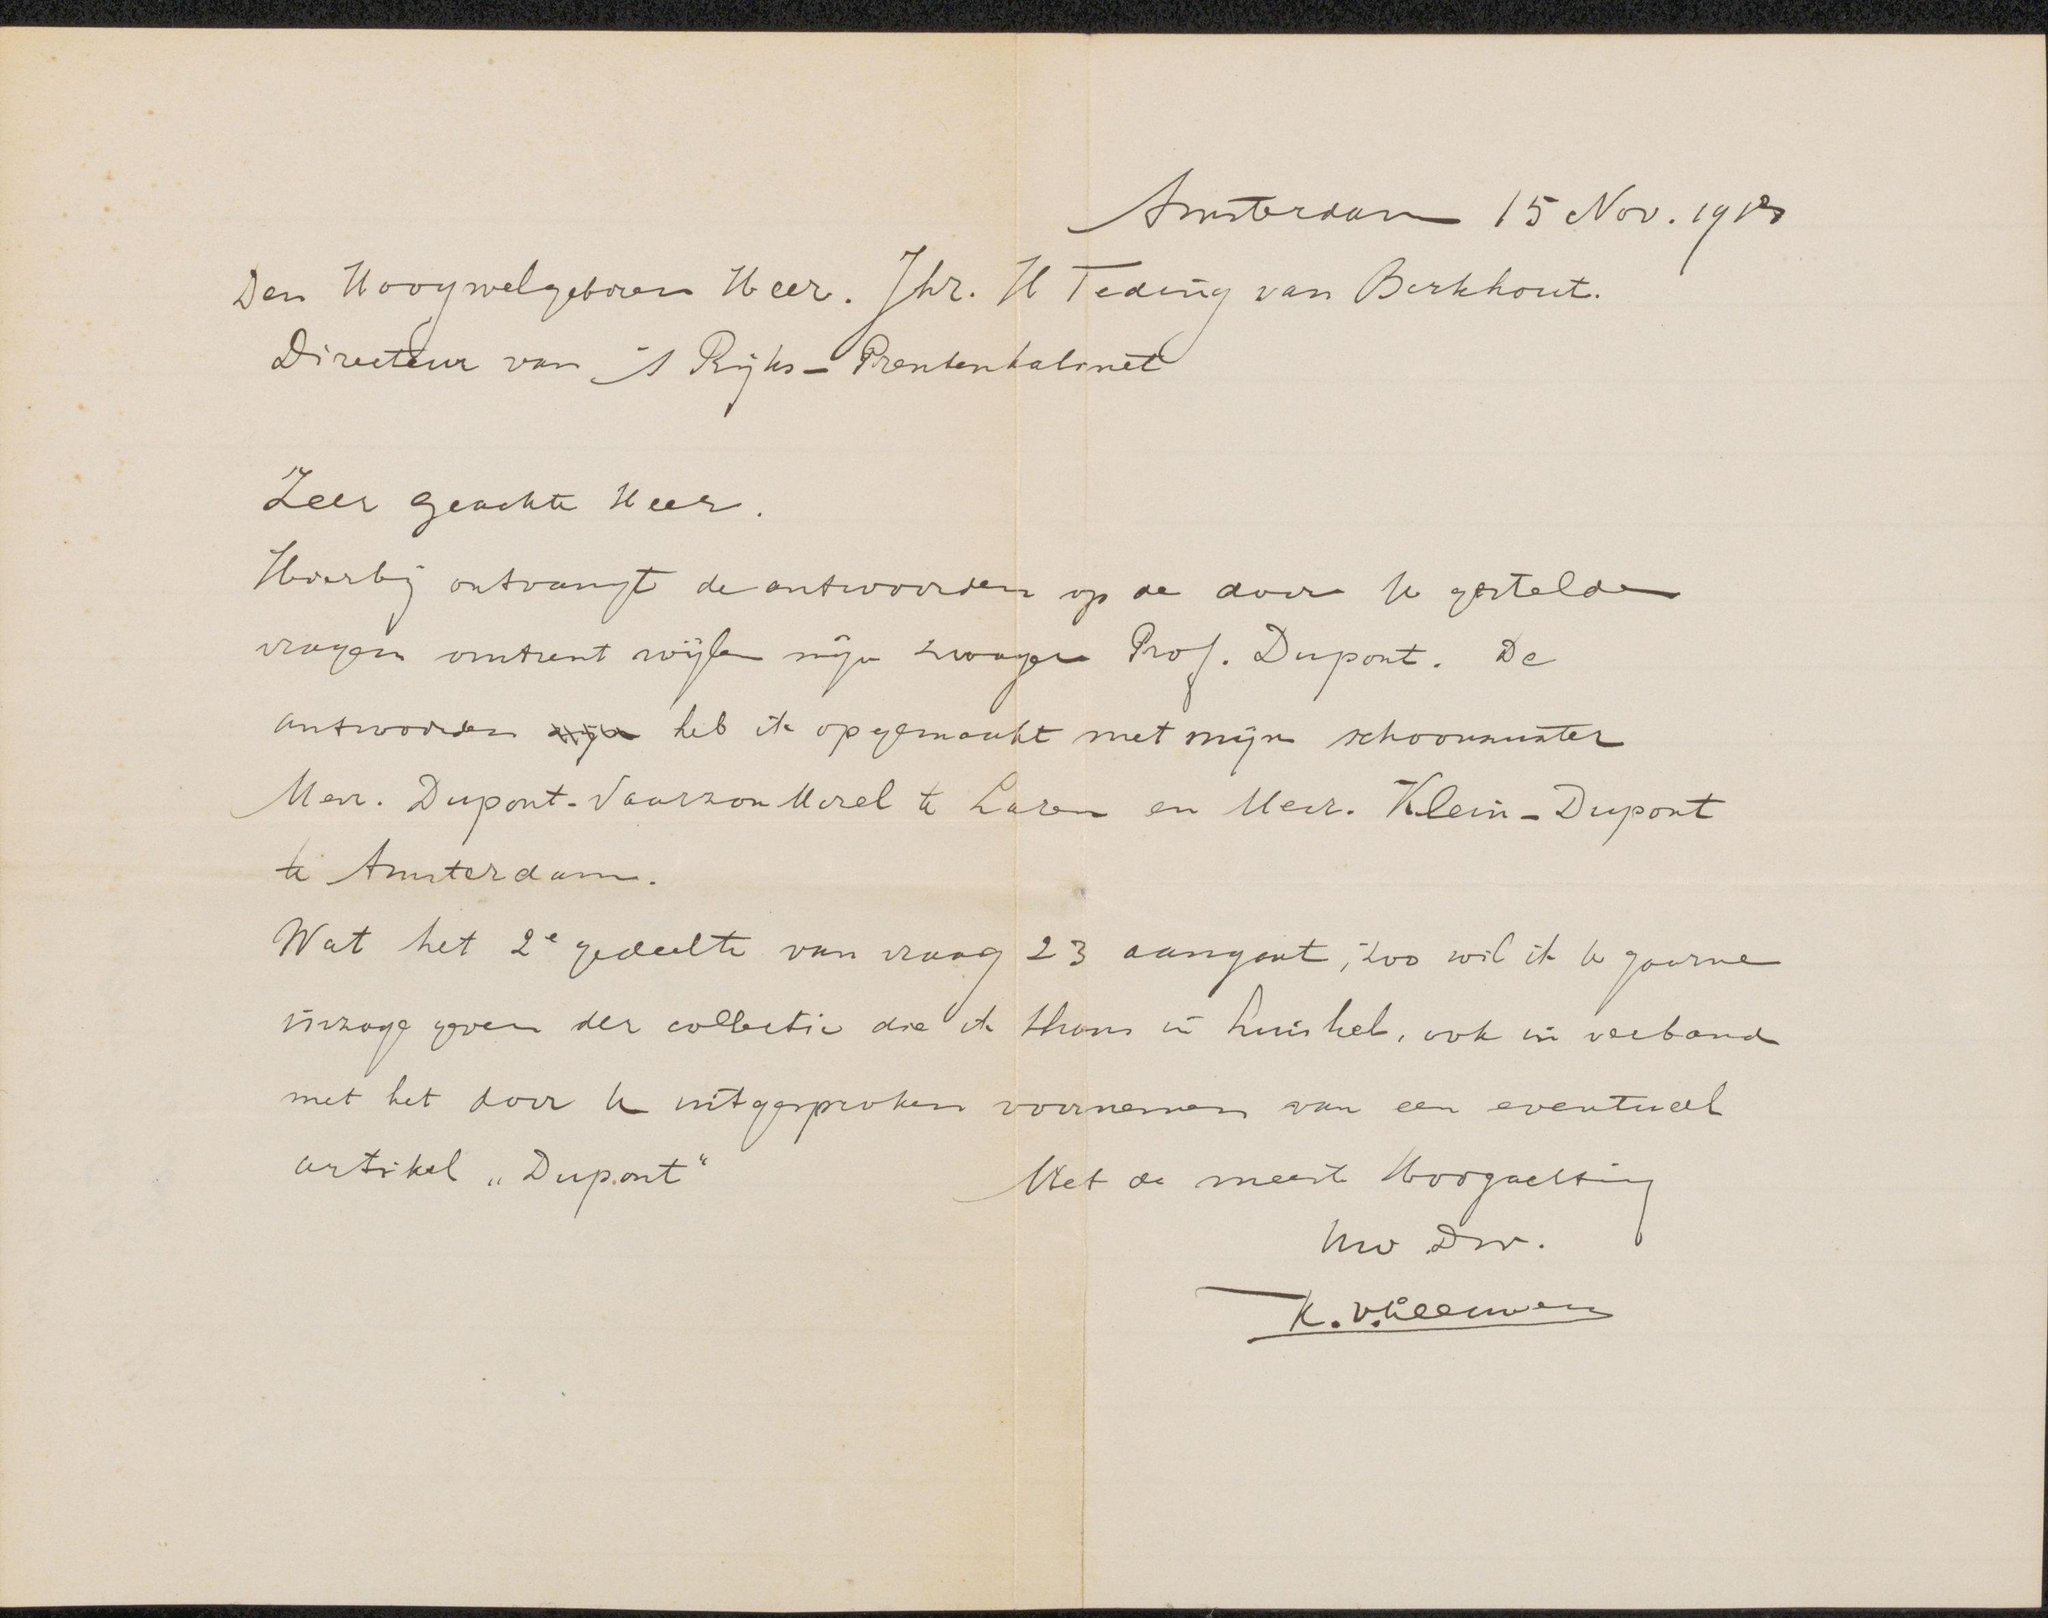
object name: letter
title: Brief aan jonkheer Hendrik Teding van Berkhout (1879-1969)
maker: klaas van leeuwen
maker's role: print maker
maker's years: 1867-1935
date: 1913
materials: ink, paper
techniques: pen, writing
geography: amsterdam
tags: print room, amsterdam, print maker, draughtsman, pieter dupont, haarlem, jonkheer hendrik teding van berkhout (1879-1969), art collecting, printed matter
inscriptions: collector's mark: ‘RPK’